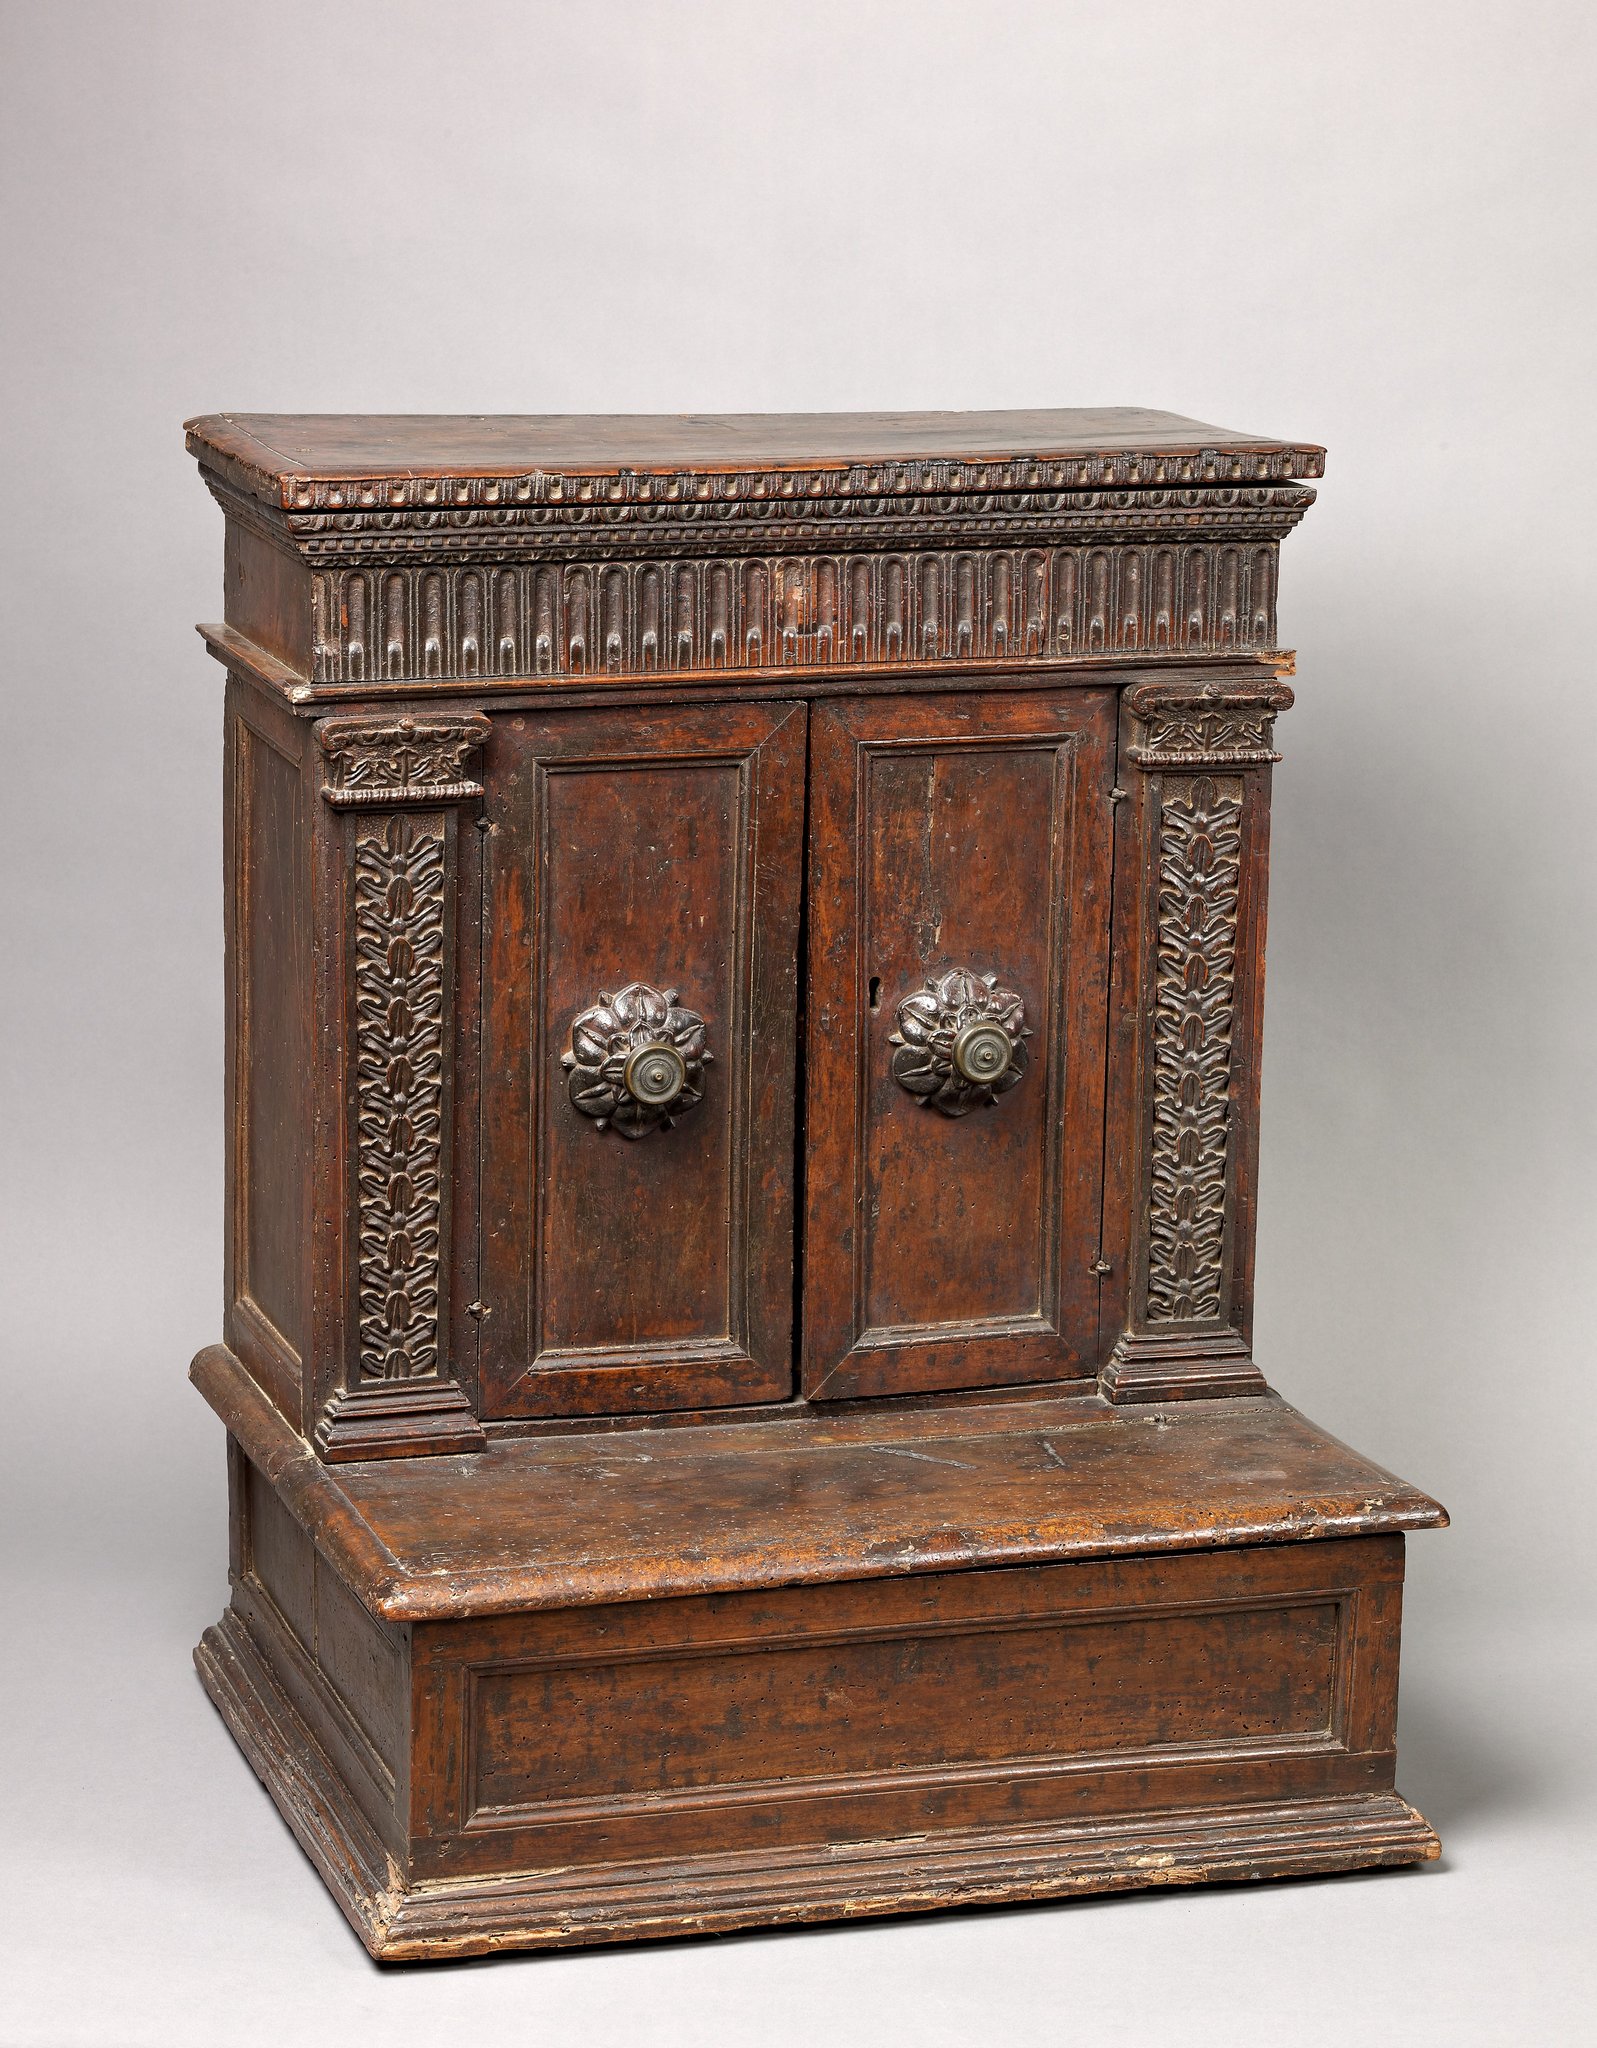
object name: prie dieu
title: Prie Dieu (Prayer desk)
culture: italian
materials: wood